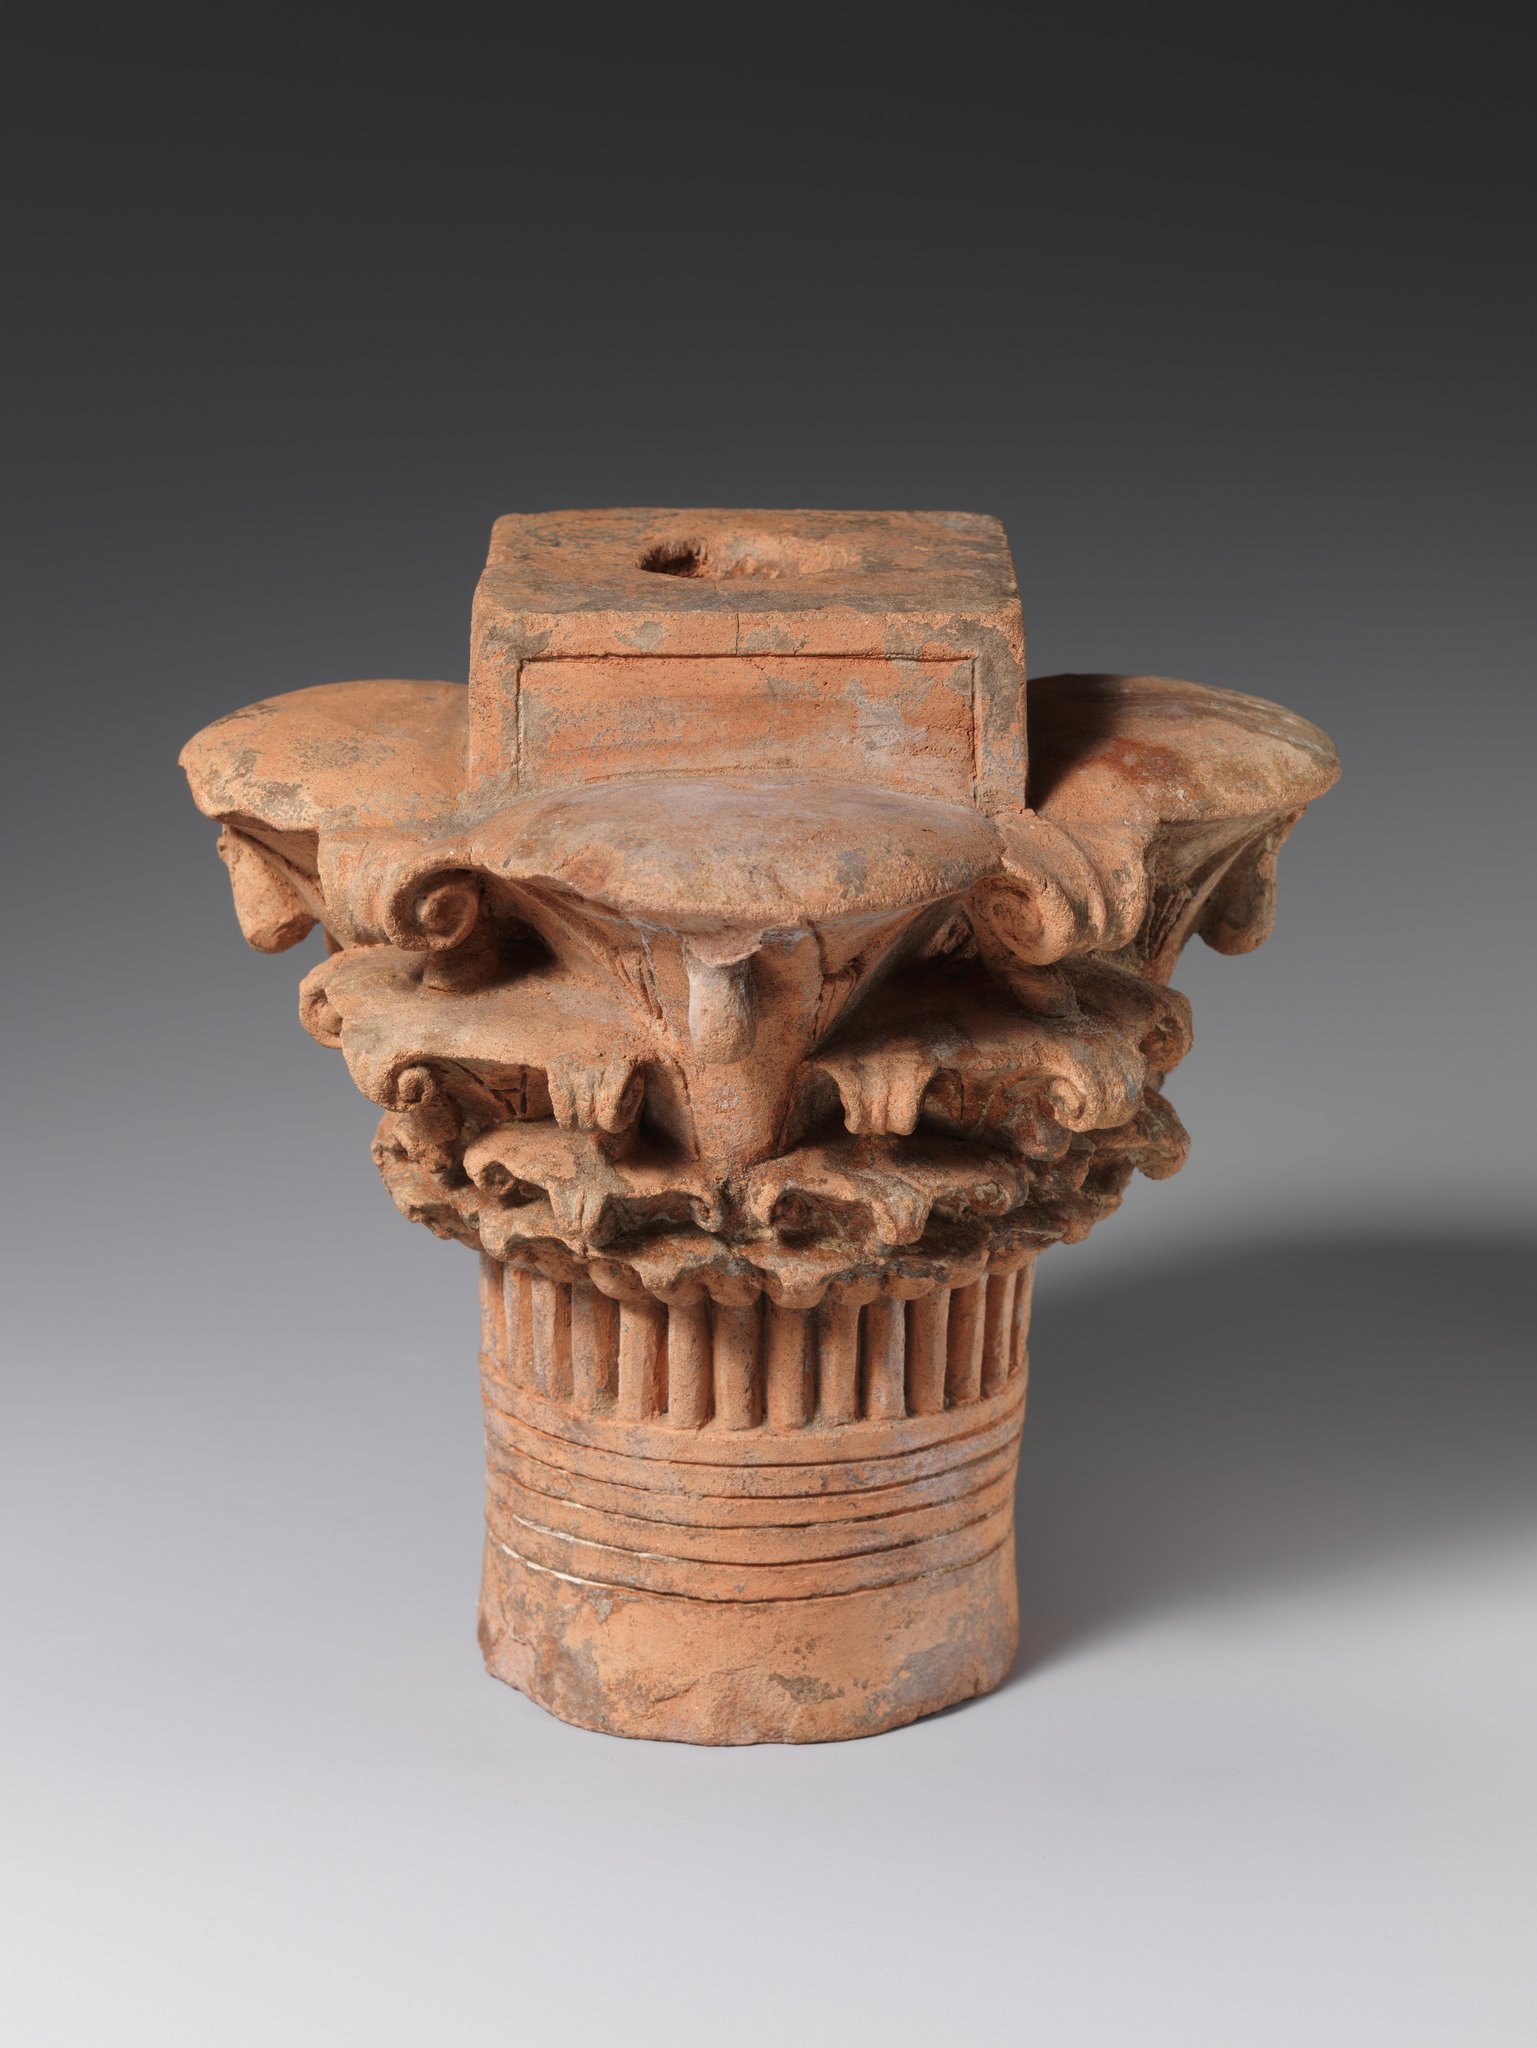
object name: column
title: Model quatrefoil 4-story lily capital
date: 400-30 BCE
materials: pottery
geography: egypt